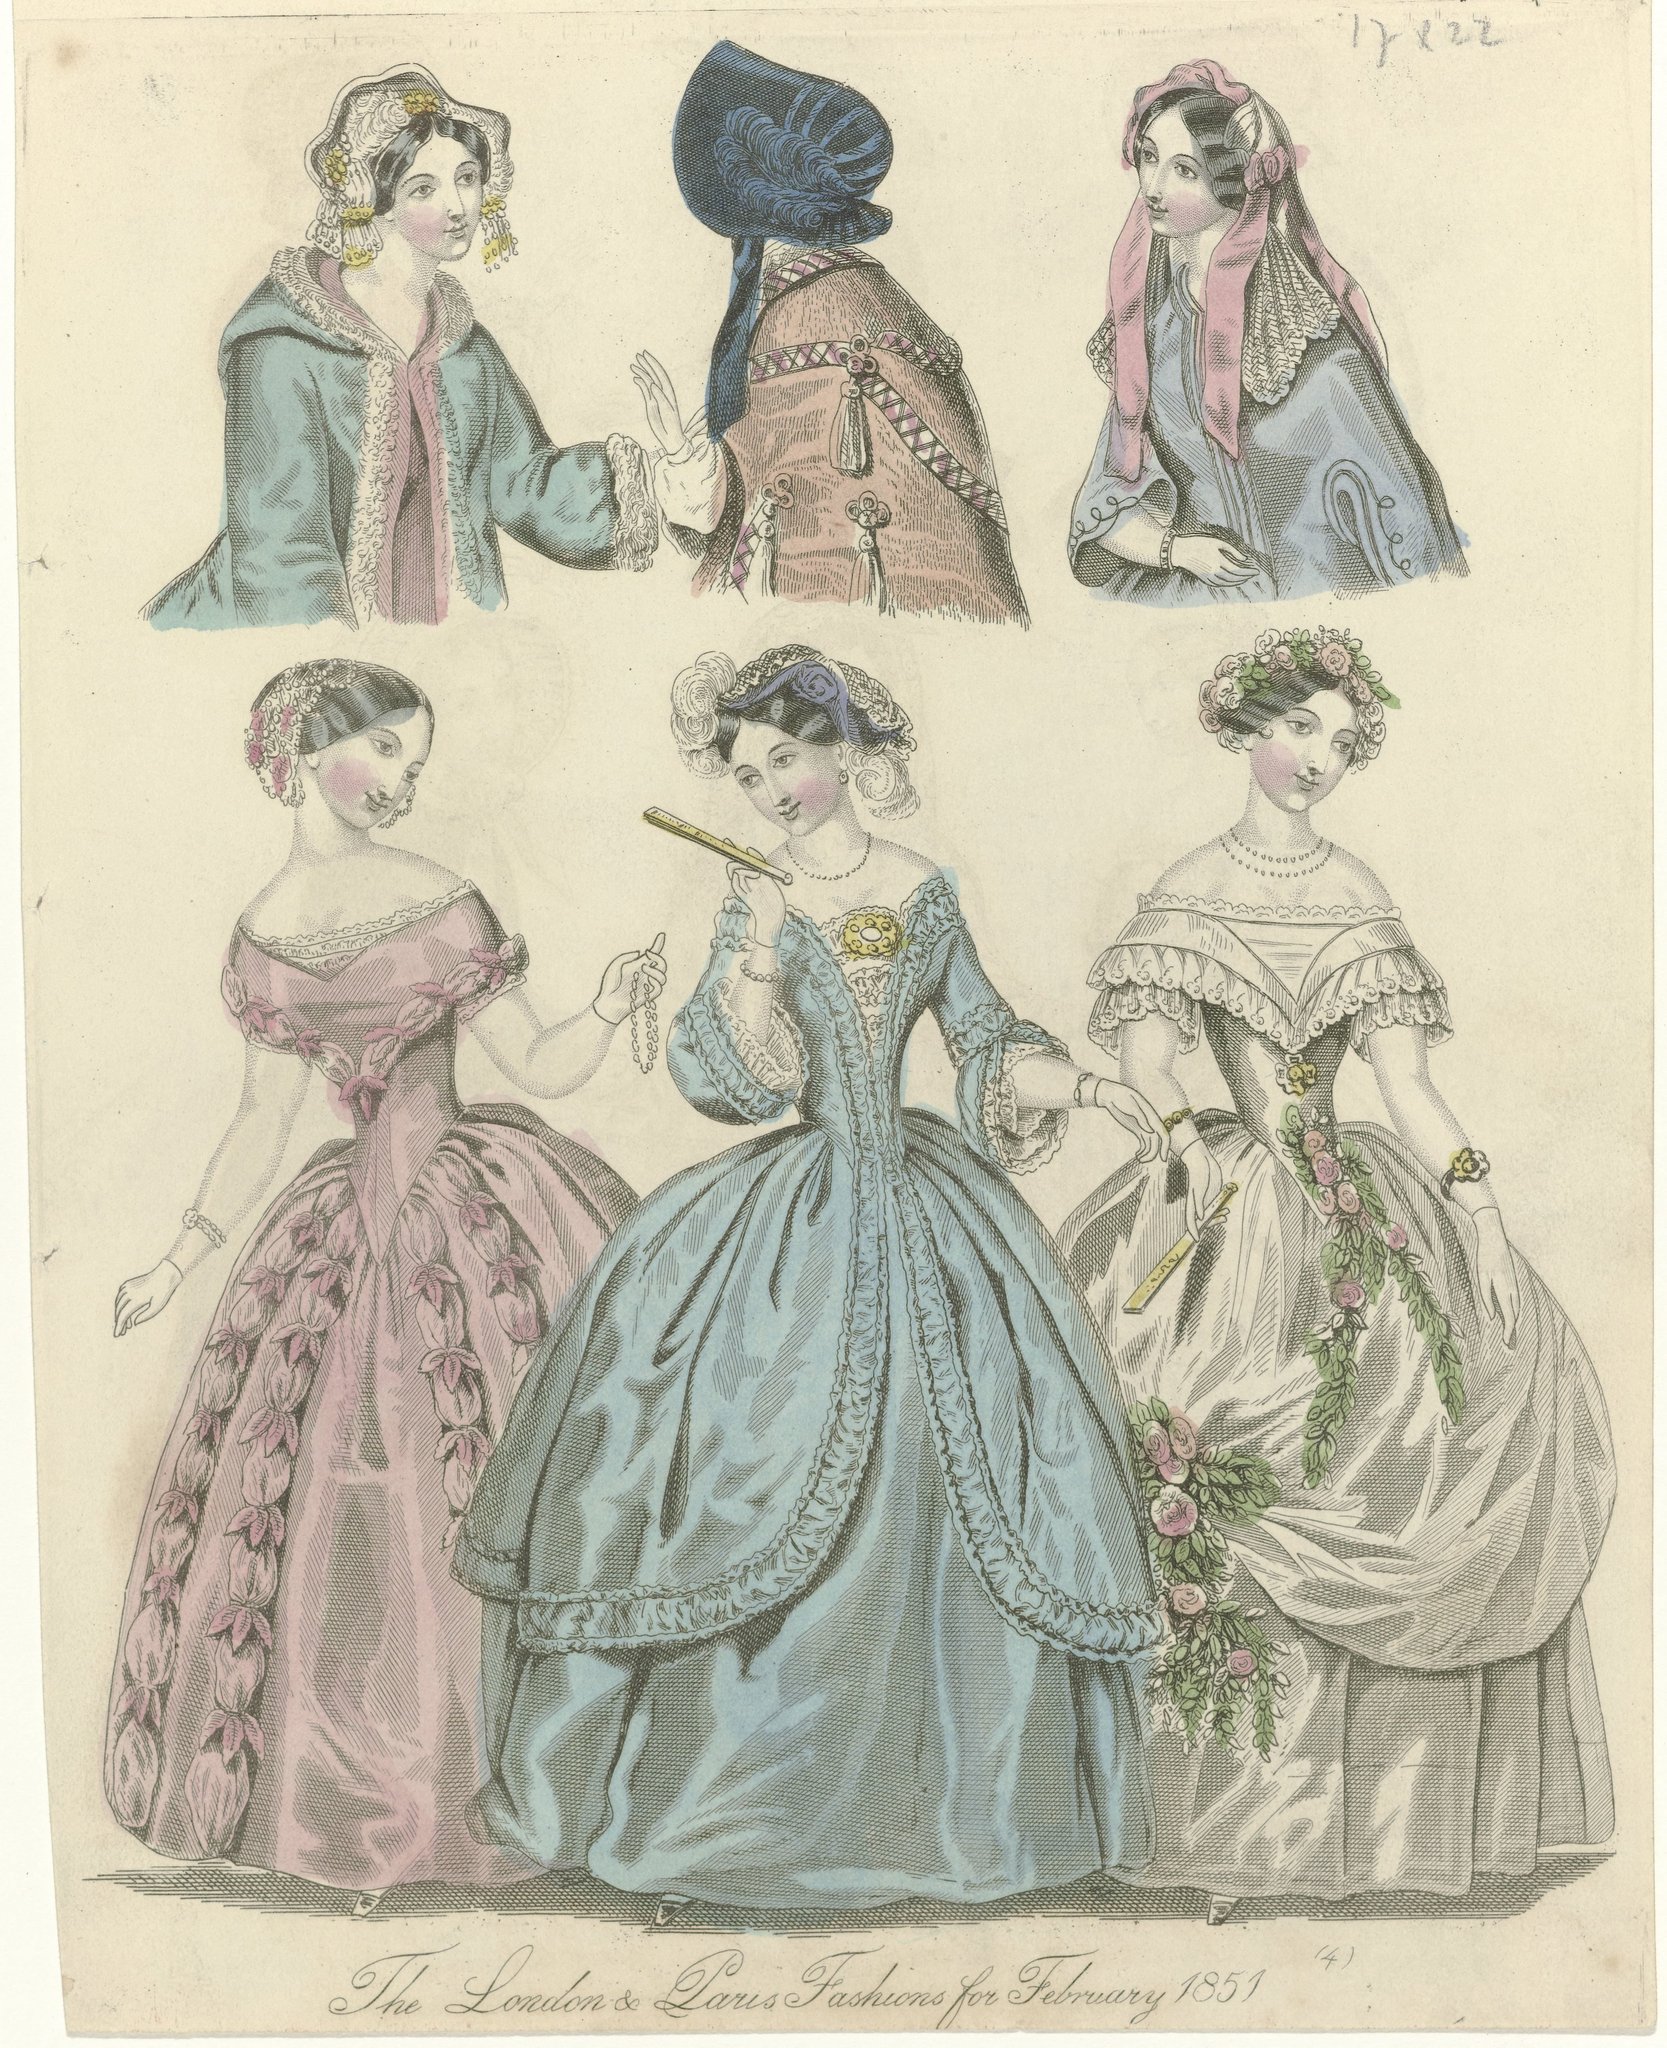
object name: fashion print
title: The World of Fashion, february 1851 : The London & Paris Fashions (...)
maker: Anonymous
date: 1851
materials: paper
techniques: etching, hand coloring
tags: ear-rings (+ women's clothes), brooch, agraffe, clasp (+ women's clothes), dress, gown: evening dress (+ women's clothes), coat (+ women's clothes), head-gear: cap (+ women's clothes), fashion plates, head-gear: hat (+ women's clothes), bracelet, wristlet (+ women's clothes), necklace (+ women's clothes)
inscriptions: caption: ‘The London & Paris Fashions for February 1851 (4)’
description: Modes voor februari 1851 uit Londen en Parijs. Drie vrouwen, staande, in avondjaponnen met boothals en puntig lijfje. Accessoires: oorbel in het linkeroor, collier, broche, waaier, korte handschoenen, armbanden om beide polsen. Drie vrouwen, ten halven lijve, in verschillende mantels. Baret(?), luifelhoed met struisveer en muts met linten. Prent uit het modetijdschrift The World of Fashion (1824-1891).